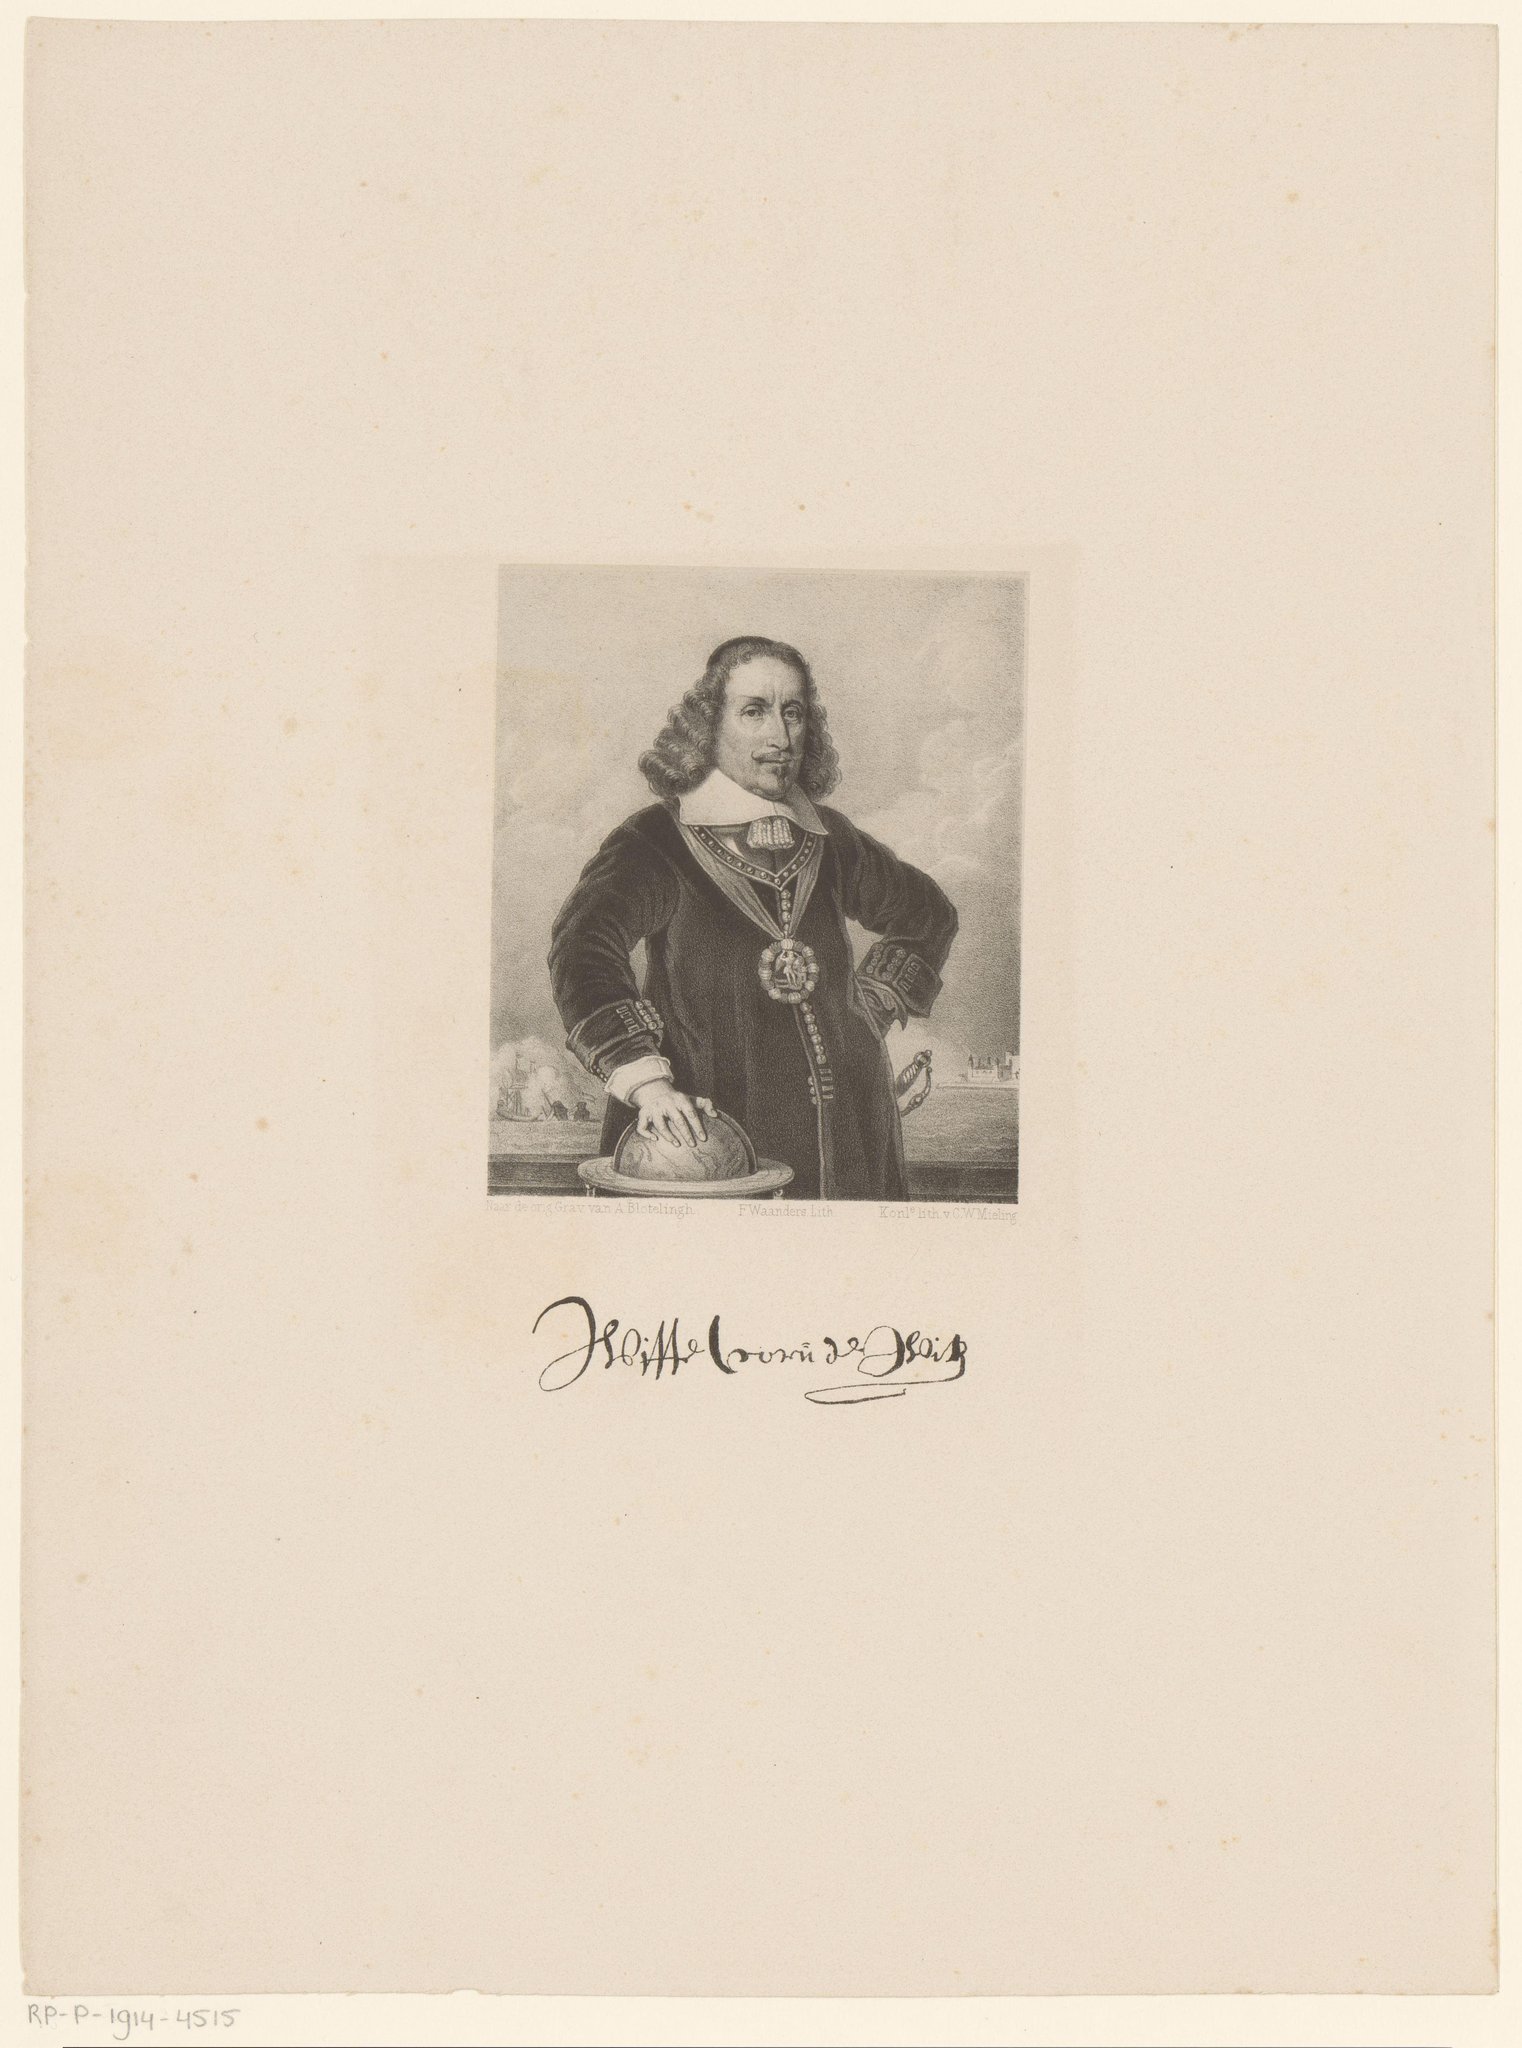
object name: print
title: Portret van Witte Cornelisz. de With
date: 1847-1865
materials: paper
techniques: lithograph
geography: the hague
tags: historical persons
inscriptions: collector's mark: Lugt 2228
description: Onder het portret de signatuur van de geportretteerde.